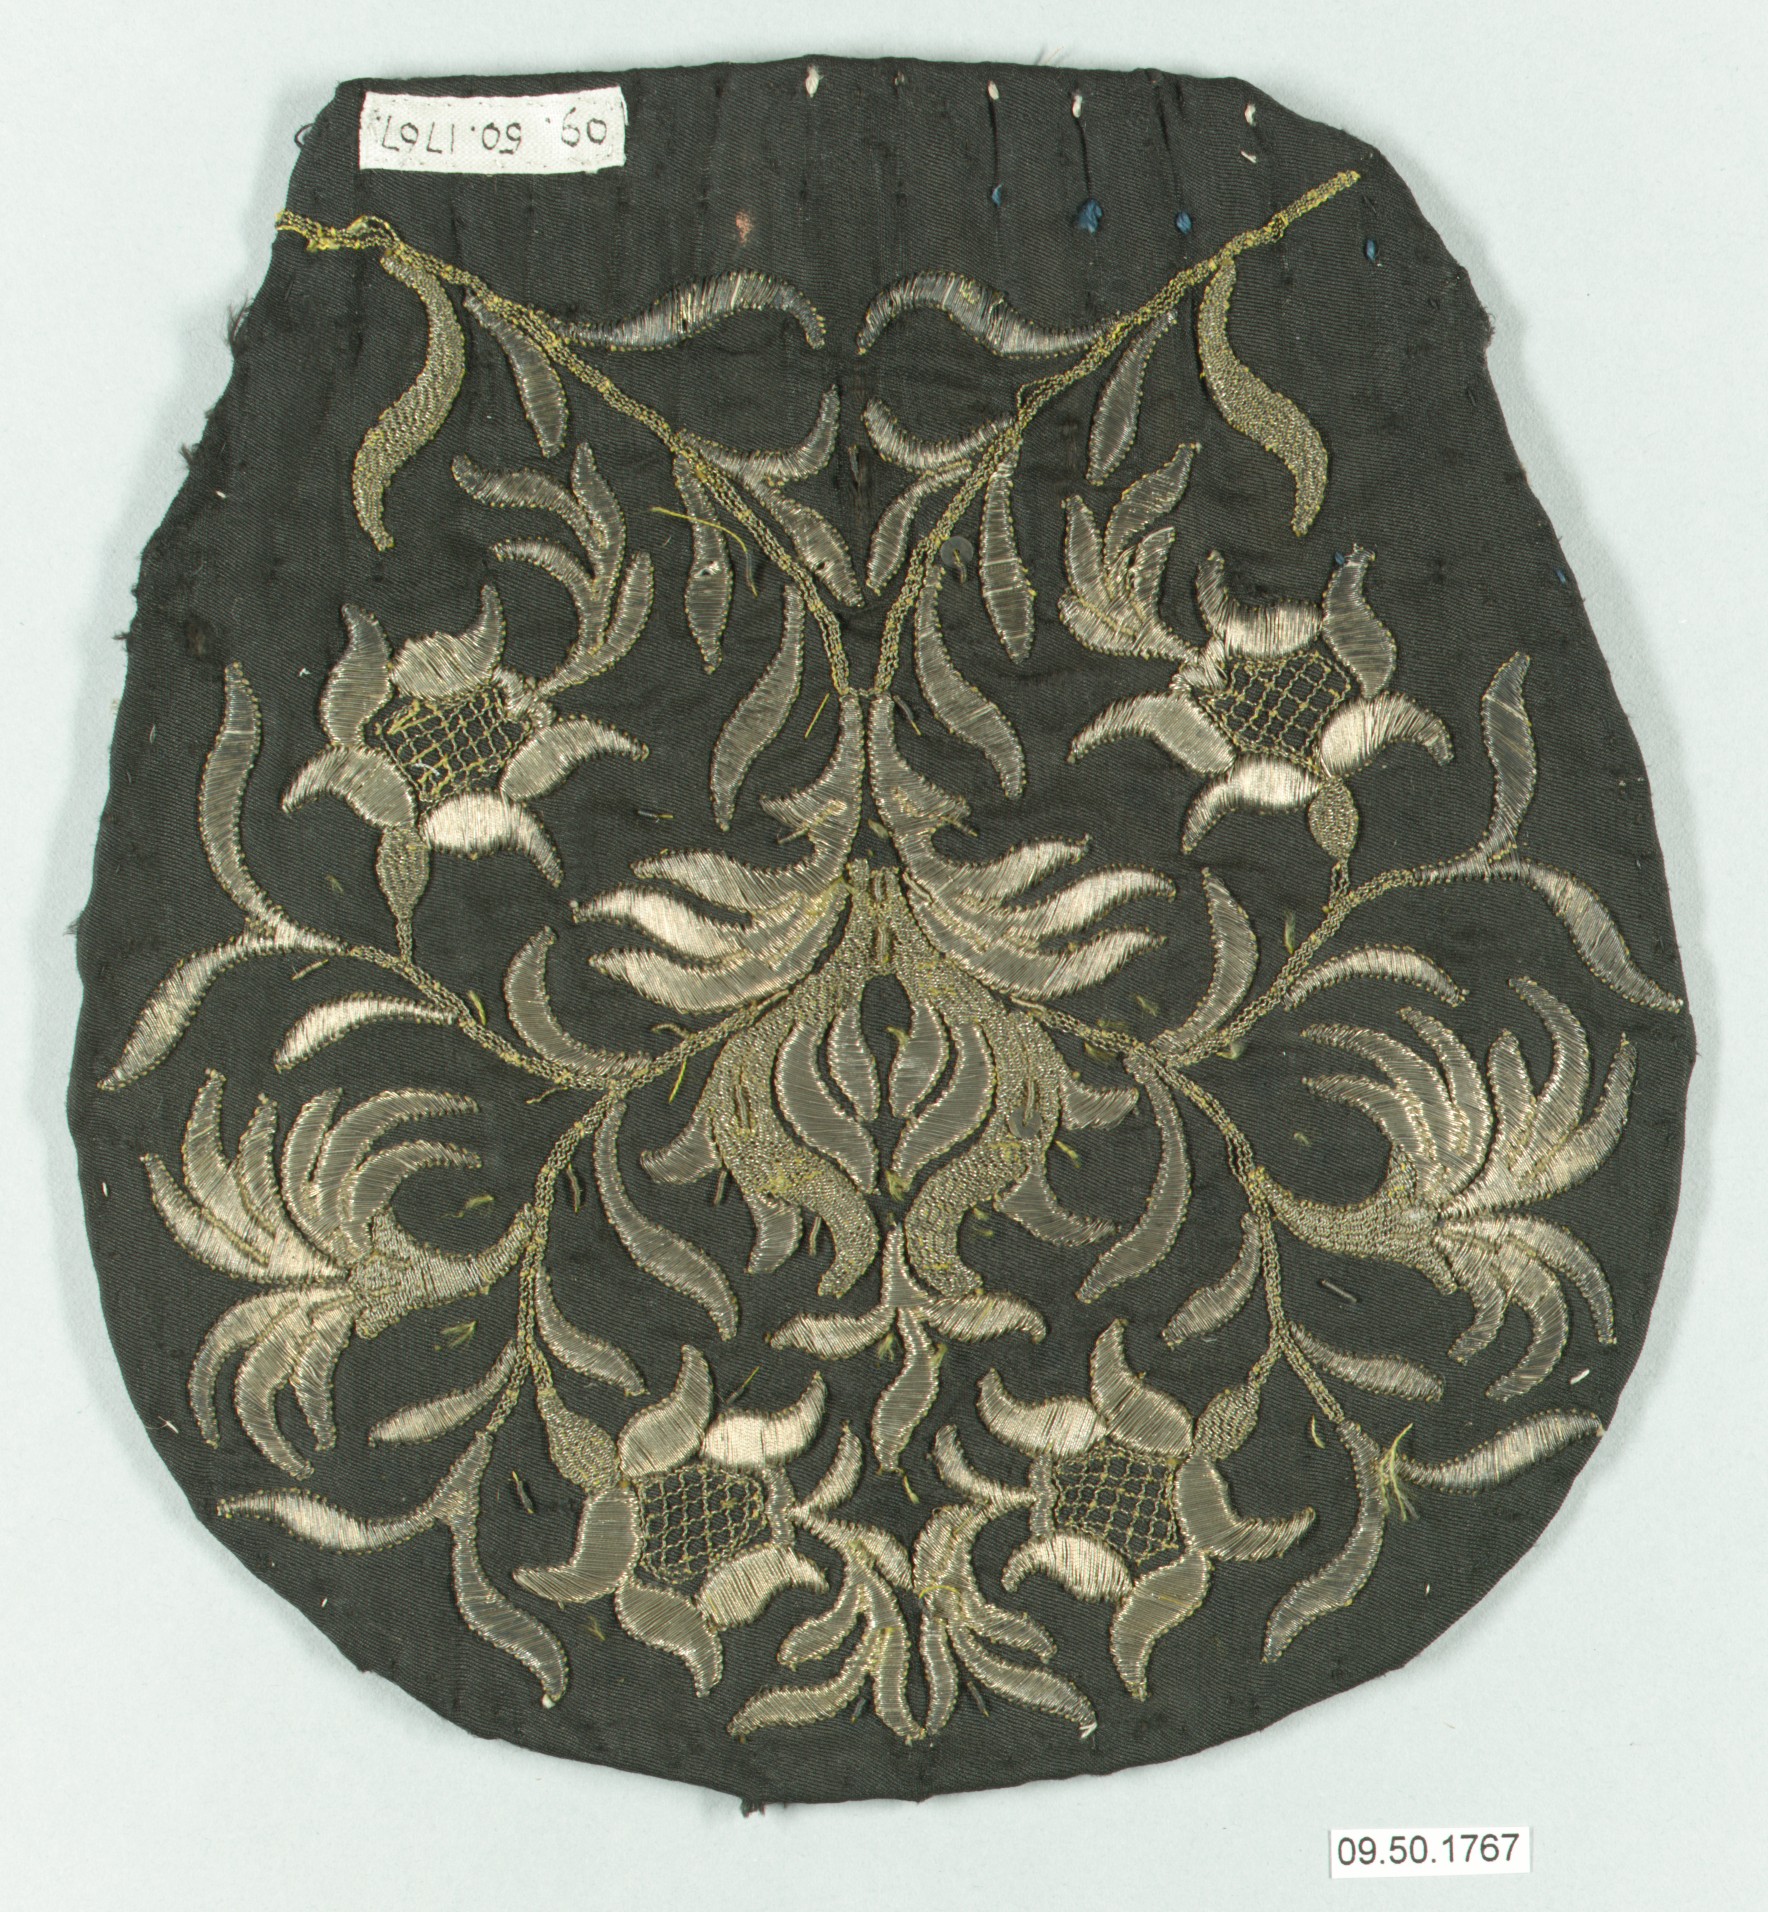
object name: cap crown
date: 1801-1900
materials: metal thread, silk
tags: flowers